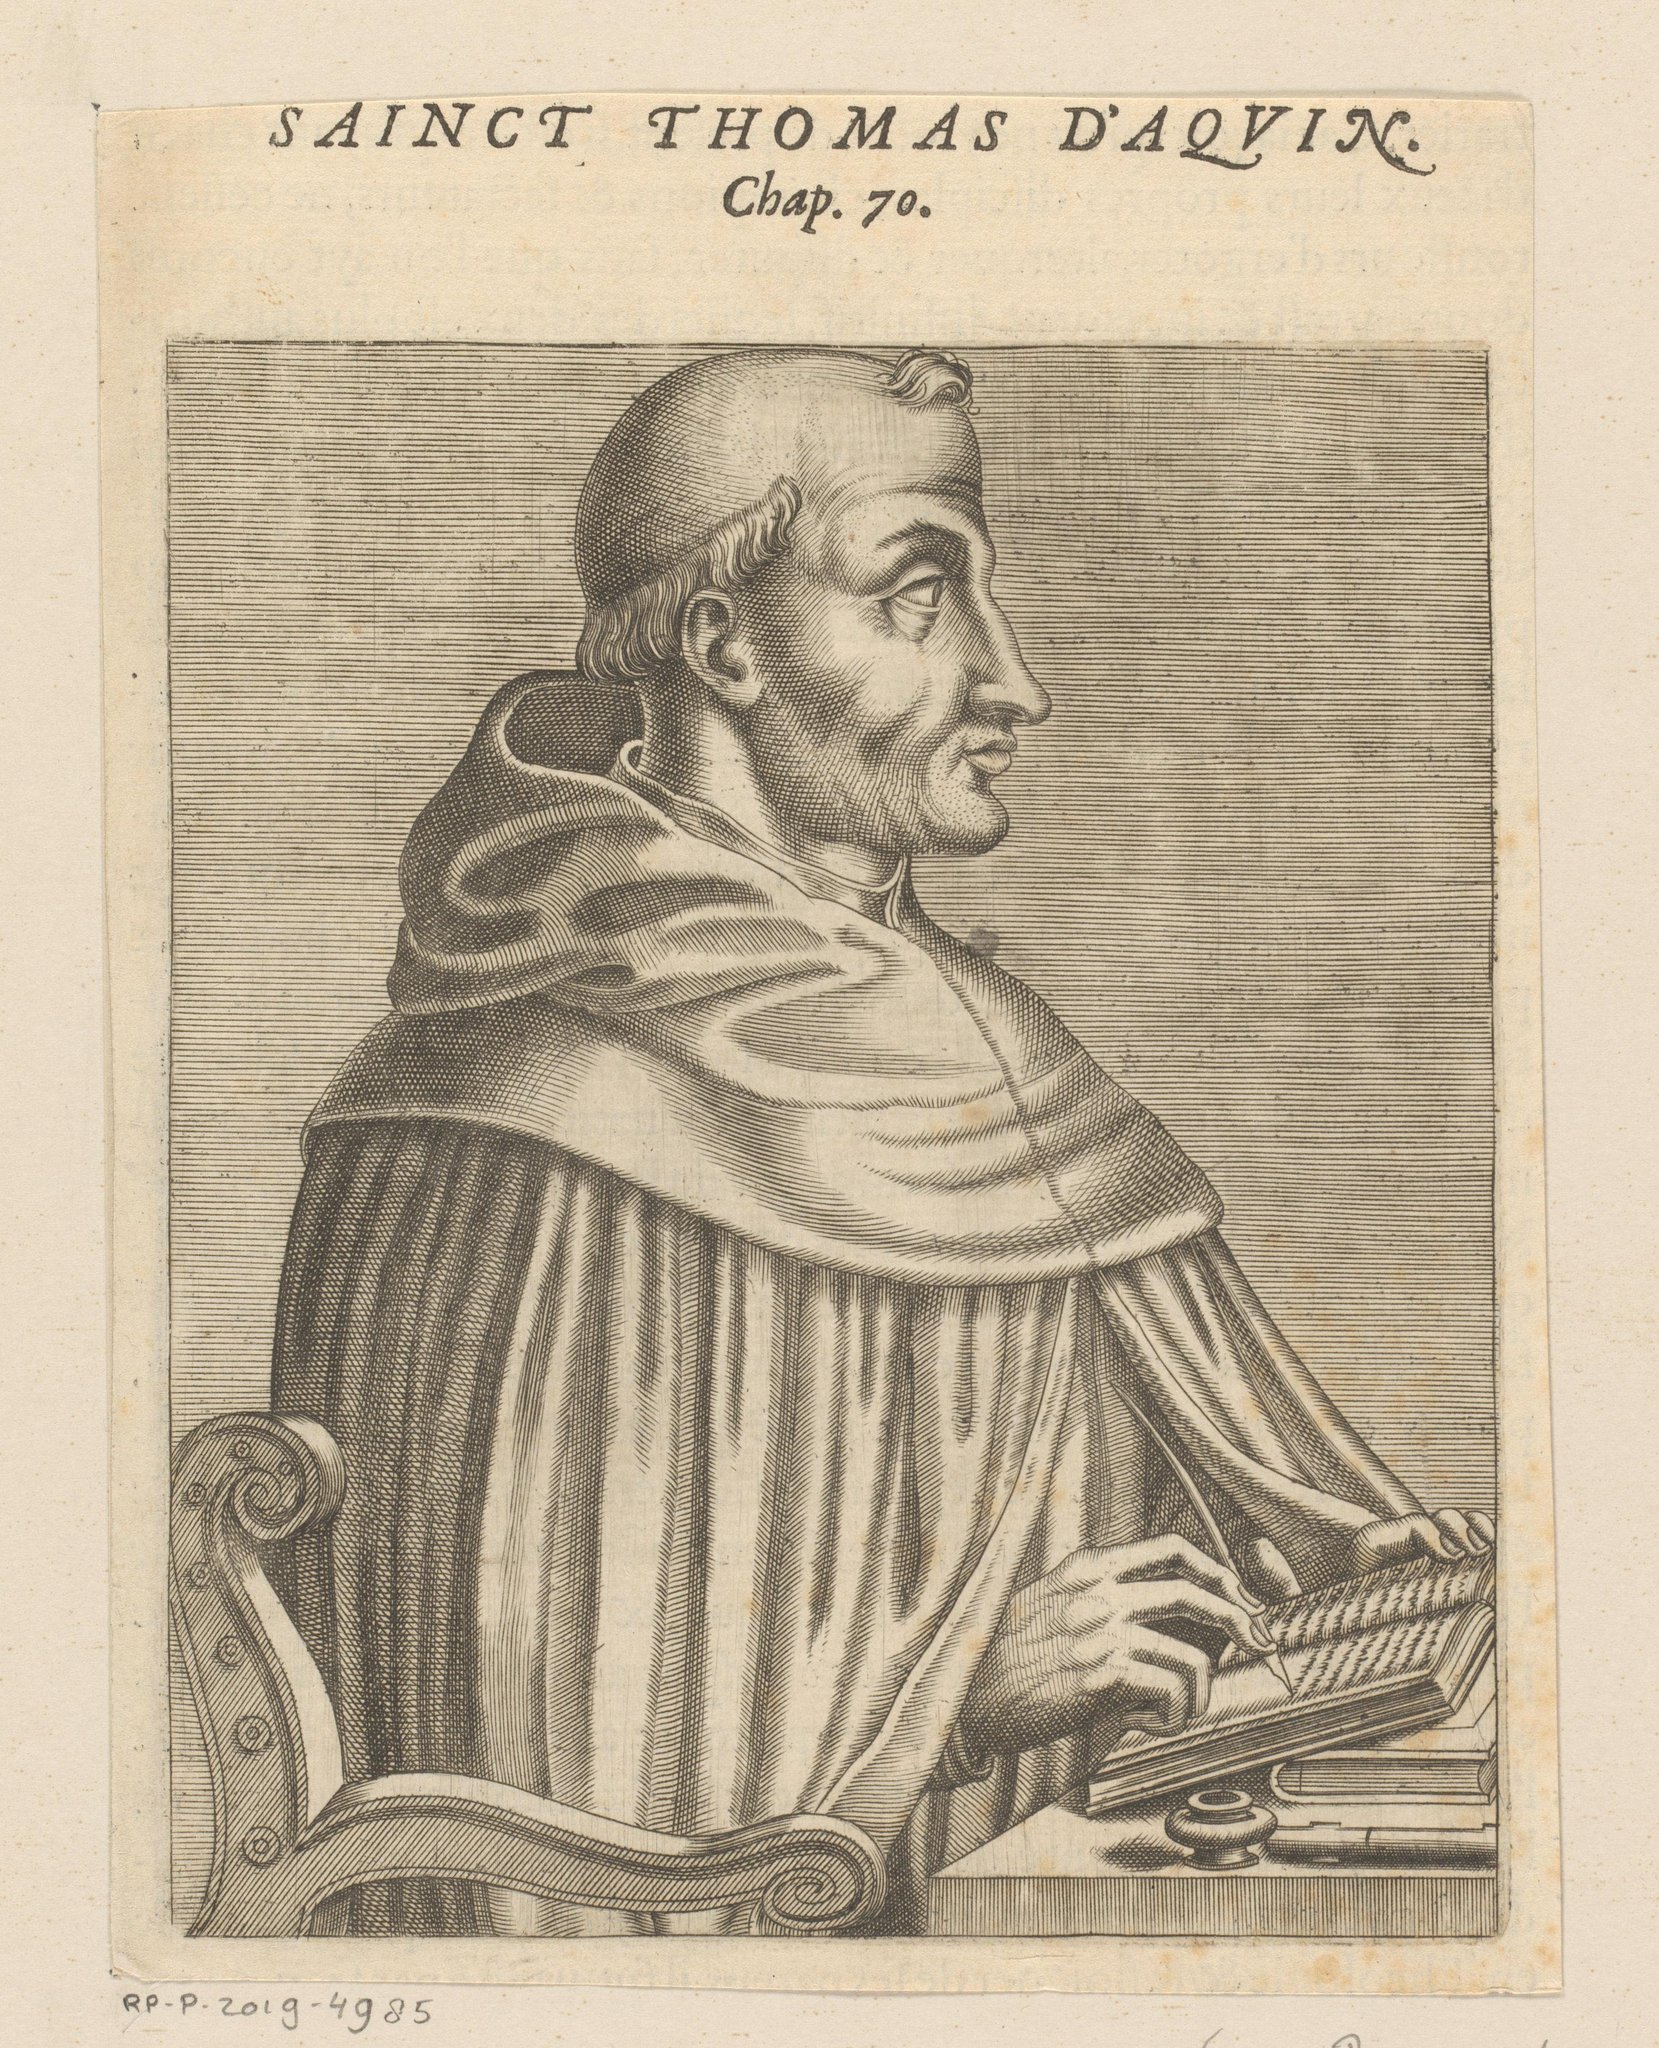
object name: book illustration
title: Portret van Thomas van Aquino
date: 1584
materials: paper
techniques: engraving, letterpress printing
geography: paris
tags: thomas van aquino, historical persons, book, the dominican theologian, 'angelic doctor' thomas of aquino; possible attributes: book, (chain with) sun, dove, girdle of chastity, lily, model of church, monstrance (or chalice), mitre (under feet), star (on breast)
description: Prent uit: Thevet, André. Les vrais pourtraits et vies des hommes illustres grecz, latins et payens (...). Parijs: weduwe Jacques Kerver en Guillaume Chaudière, 1584, dl. 1, f. 144.